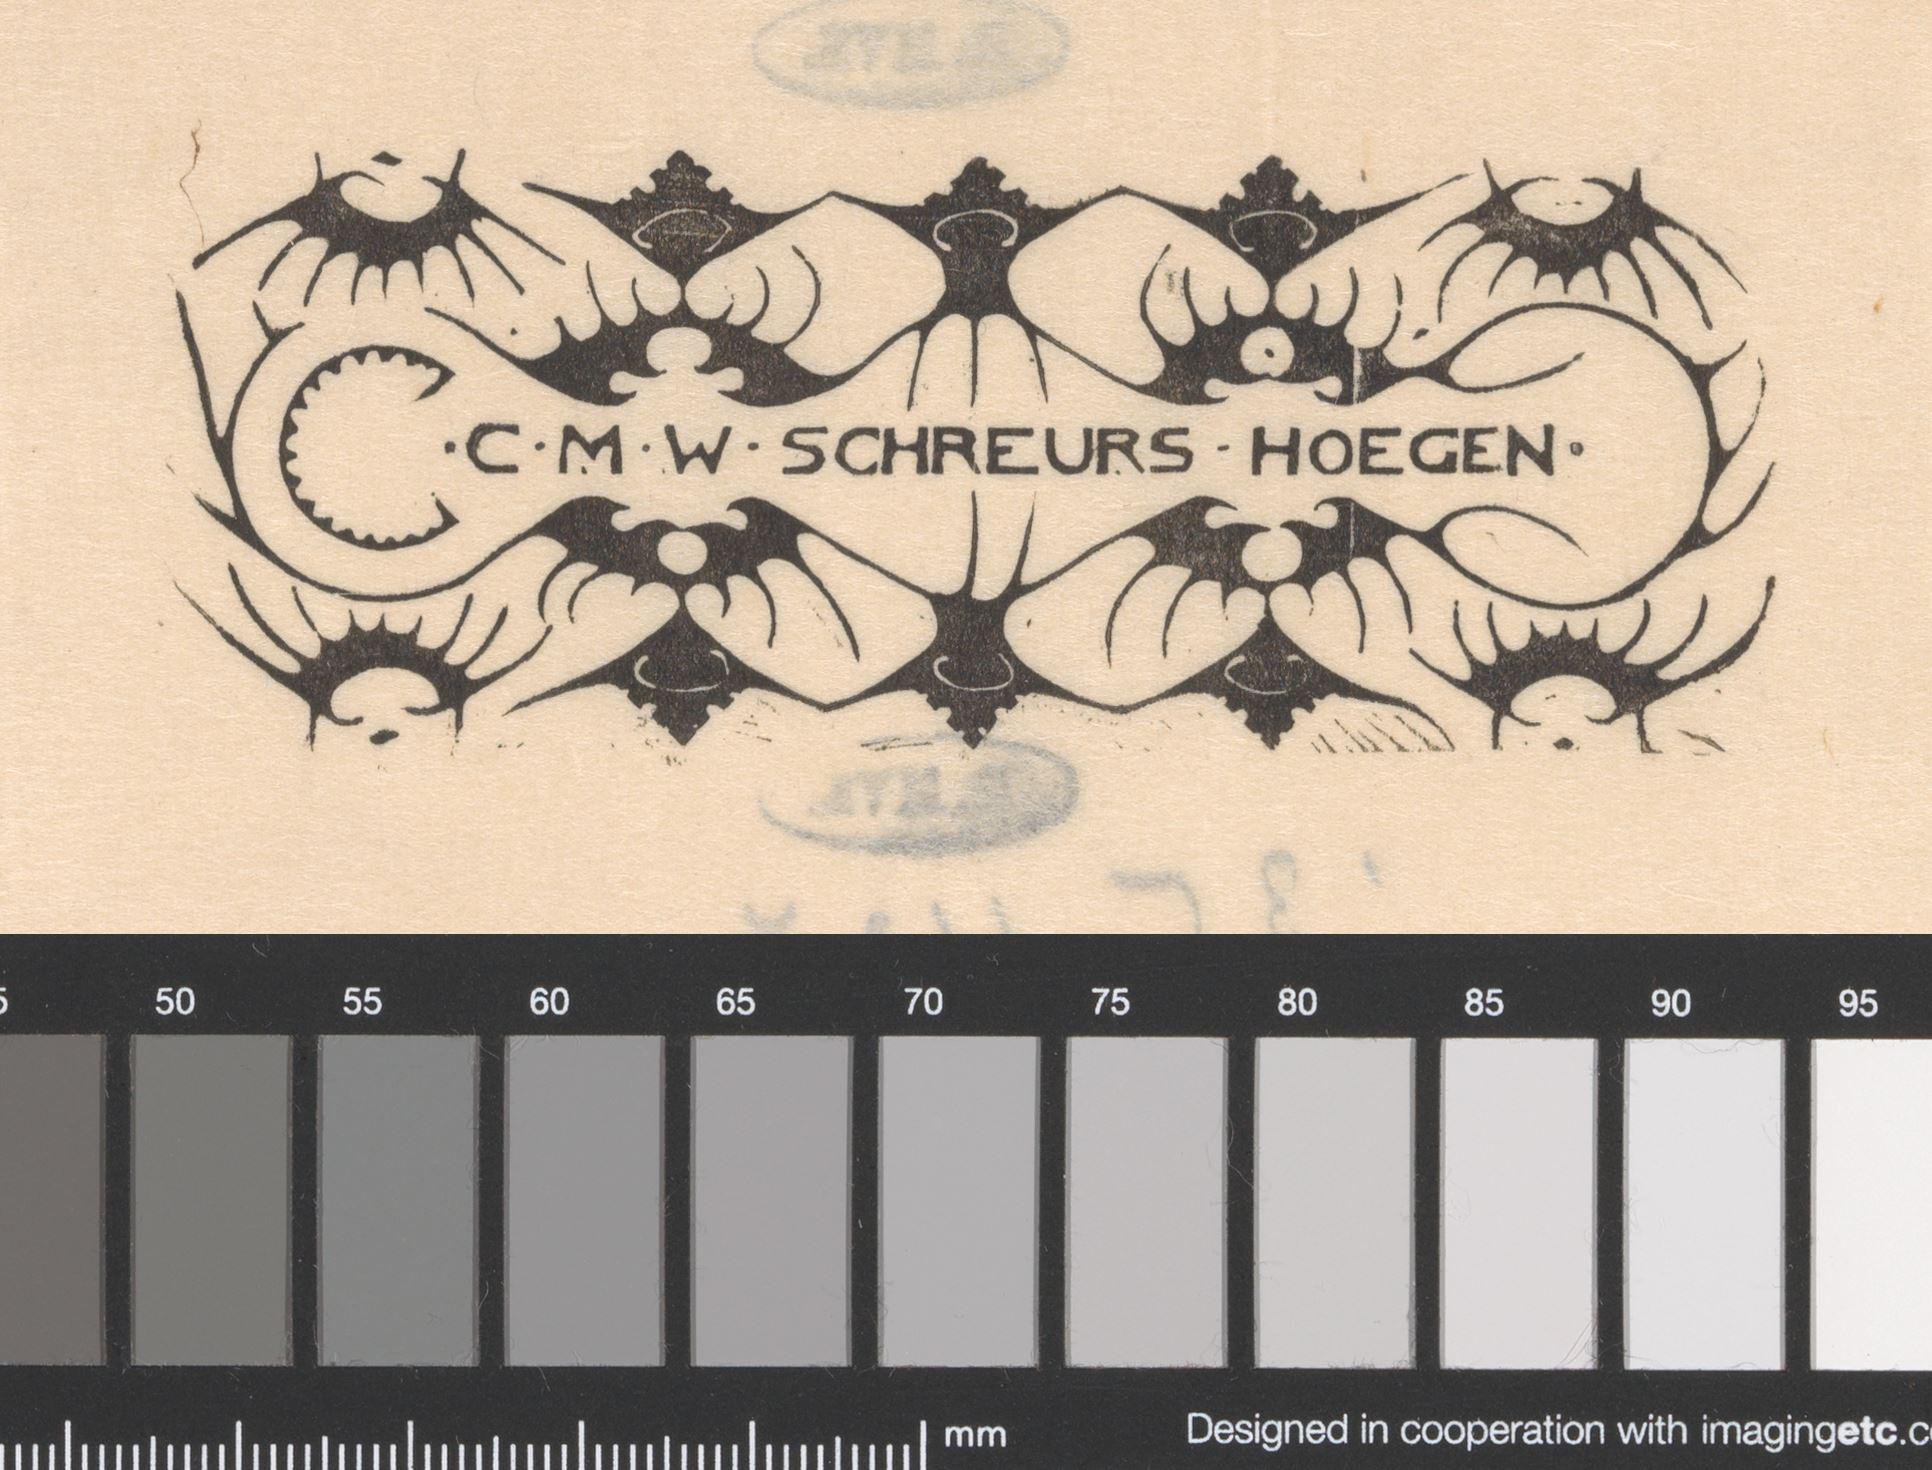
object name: print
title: Visitekaartje van C.M.W. Schreurs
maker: mathieu lauweriks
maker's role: designer, draughtsman, print maker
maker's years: 1864-1932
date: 1896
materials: paper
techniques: woodcut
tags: caroline m.w. hoegen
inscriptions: collector's mark: Lugt 2228